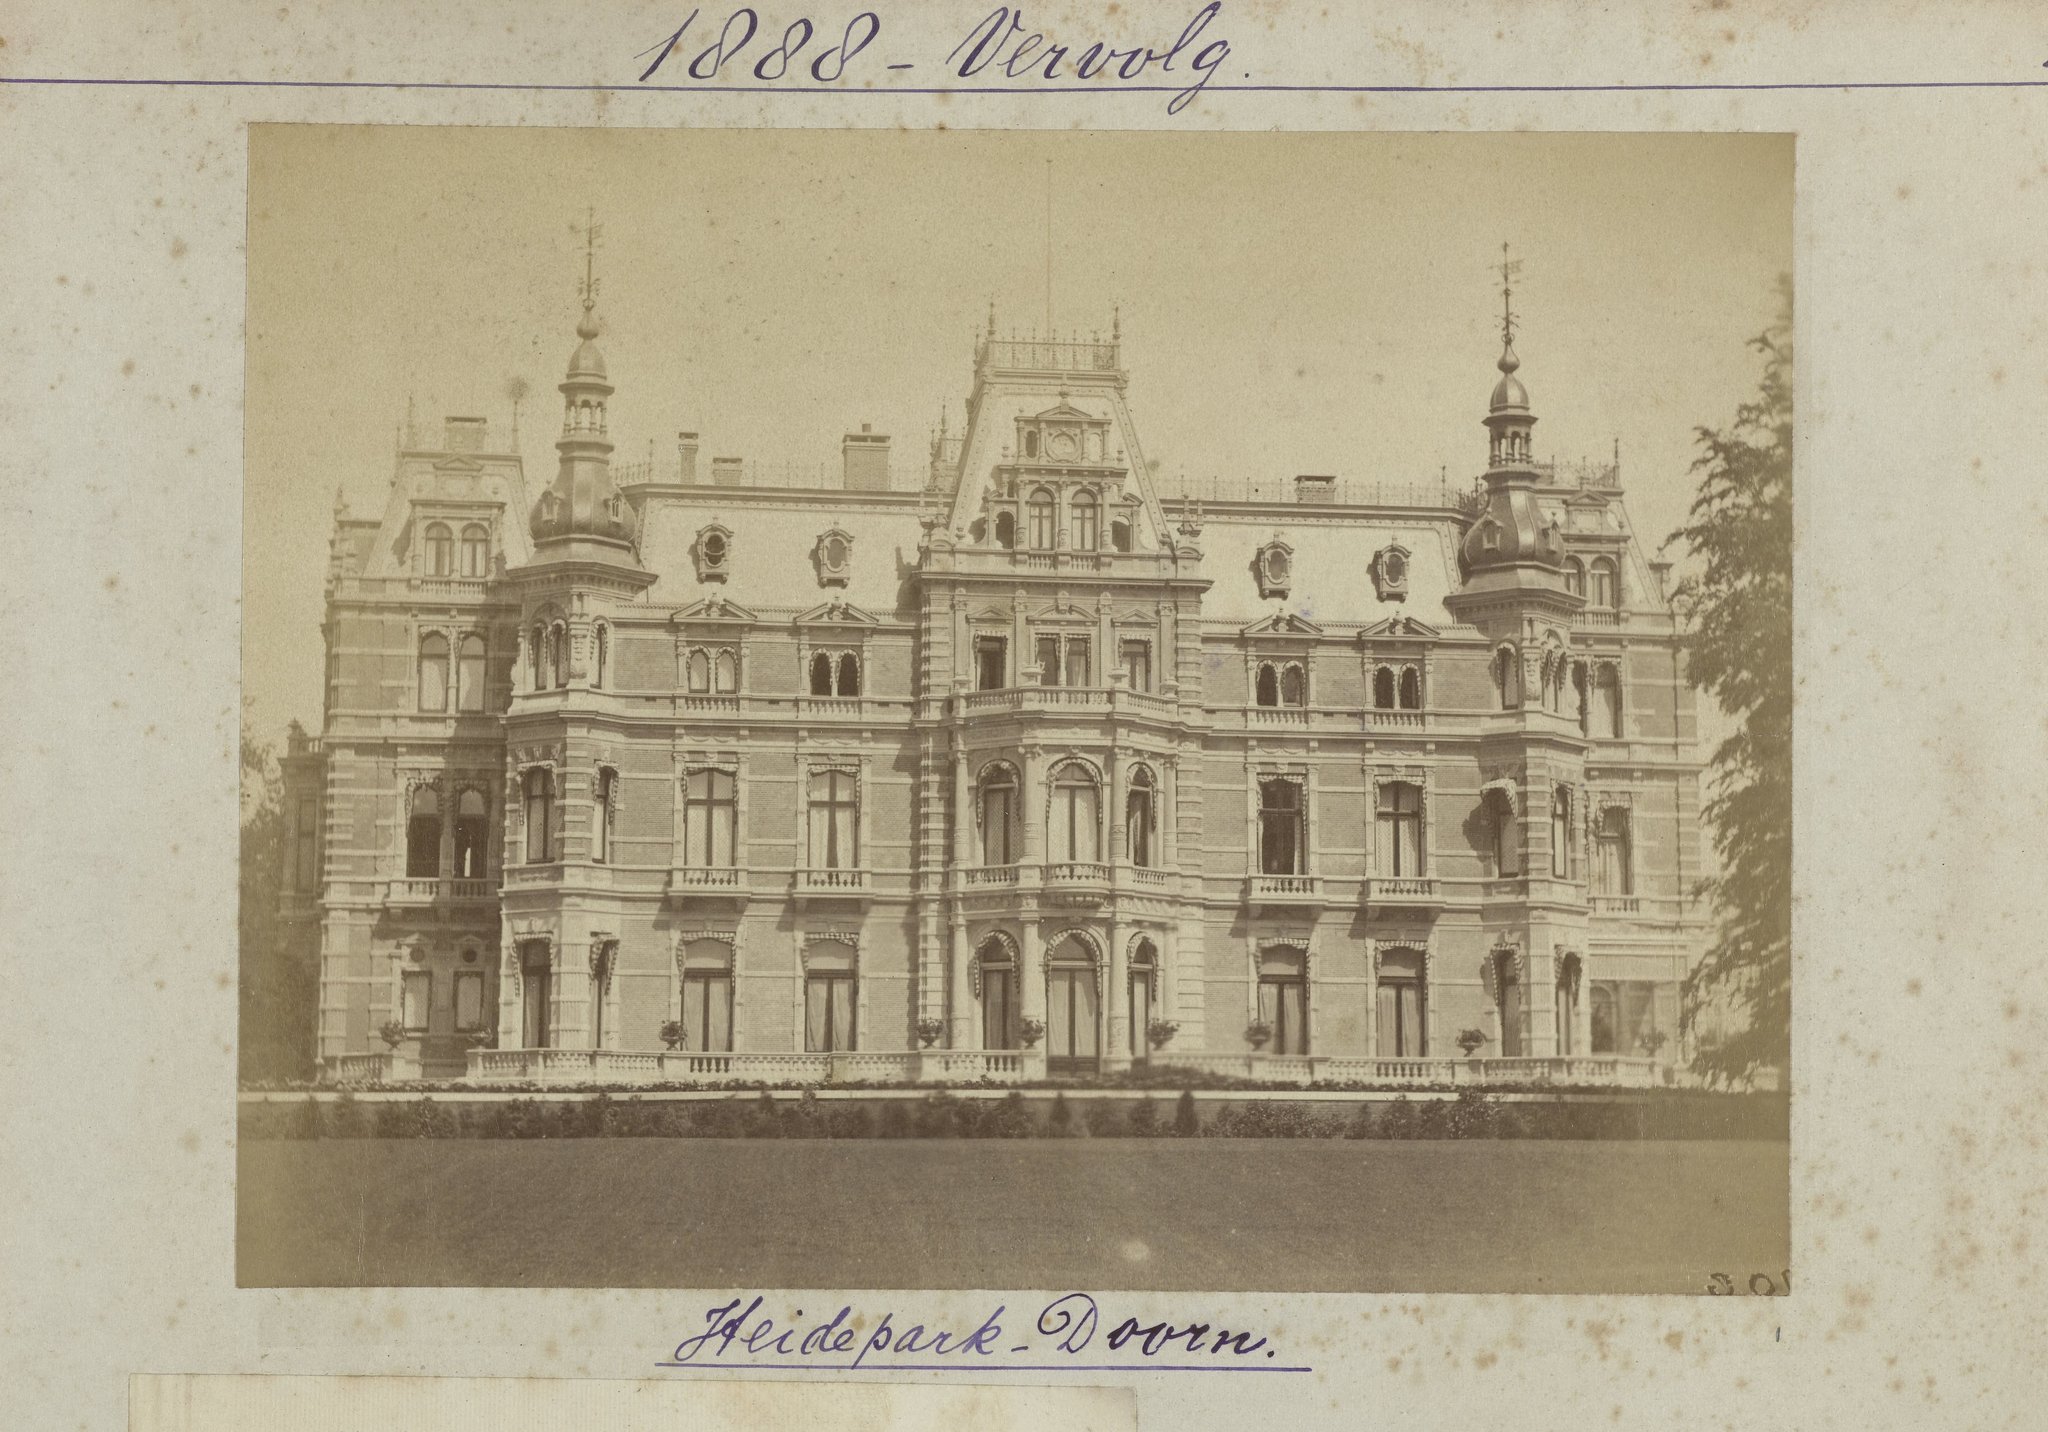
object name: photograph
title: Gezicht op landhuis Hydepark, Doorn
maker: henry pauw van wieldrecht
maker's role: fotograaf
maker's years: 1863-1912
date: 1888-1889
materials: paper, photographic support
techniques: albumen print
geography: netherlands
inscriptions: title: ‘Heidepark - Doorn’